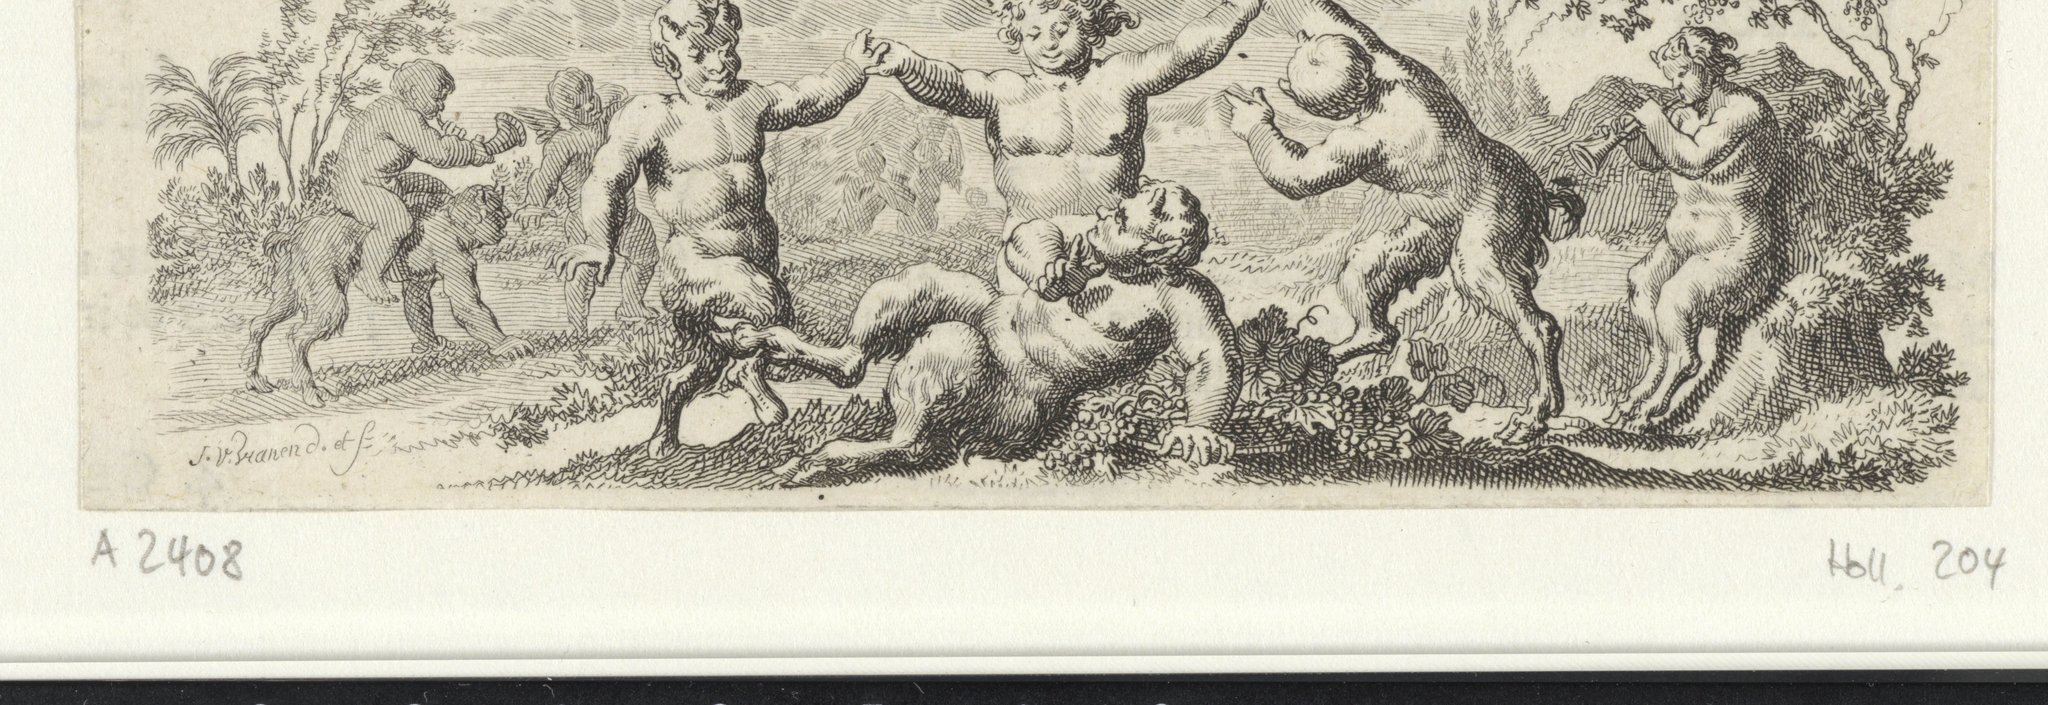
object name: print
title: Dansende jonge saters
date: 1701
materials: paper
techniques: engraving, etching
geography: amsterdam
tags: satyr(s) (in general)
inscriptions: collector's mark: Lugt 2228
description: Prent gebruikt als boekillustratie in: Phaedrus [bewerkt door D. Van Hoogstraten]. Fabularum Æsopiarum libri V. Amsterdam: François Halma, 1701.